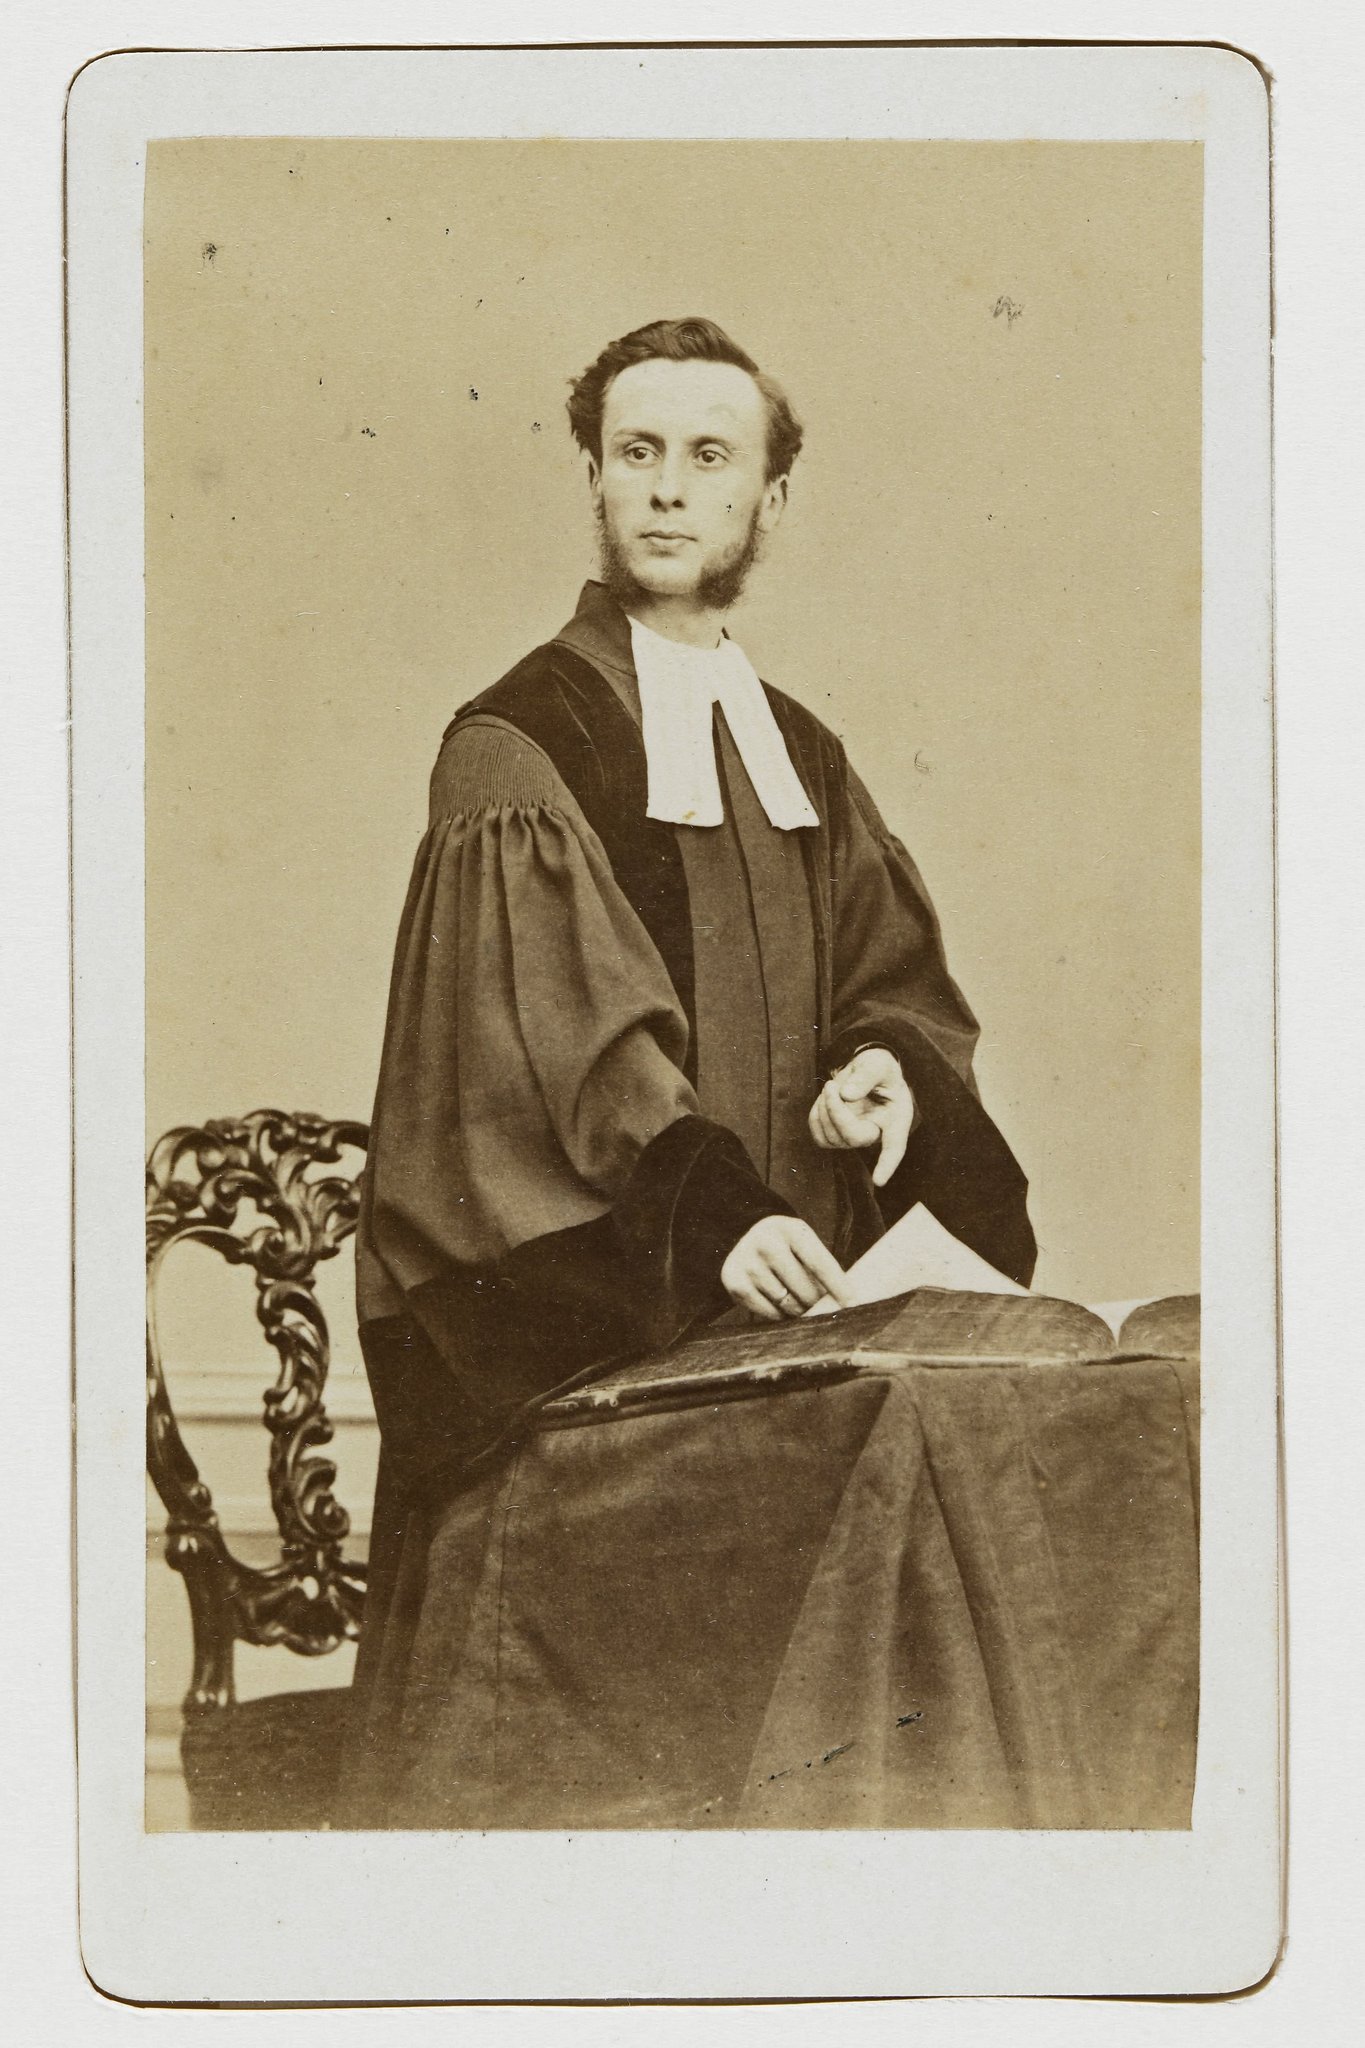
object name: carte de visite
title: Portret van de Nederlands-Hervormde predikant Auguste Chrétien Joseph van Maasdijk (1842-1916)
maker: bernardus bruining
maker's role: fotograaf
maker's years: 1834-1900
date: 1870-1880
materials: cardboard, paper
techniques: albumen print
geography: leiden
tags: historical persons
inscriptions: signature: ‘B. Bruining Leyden’